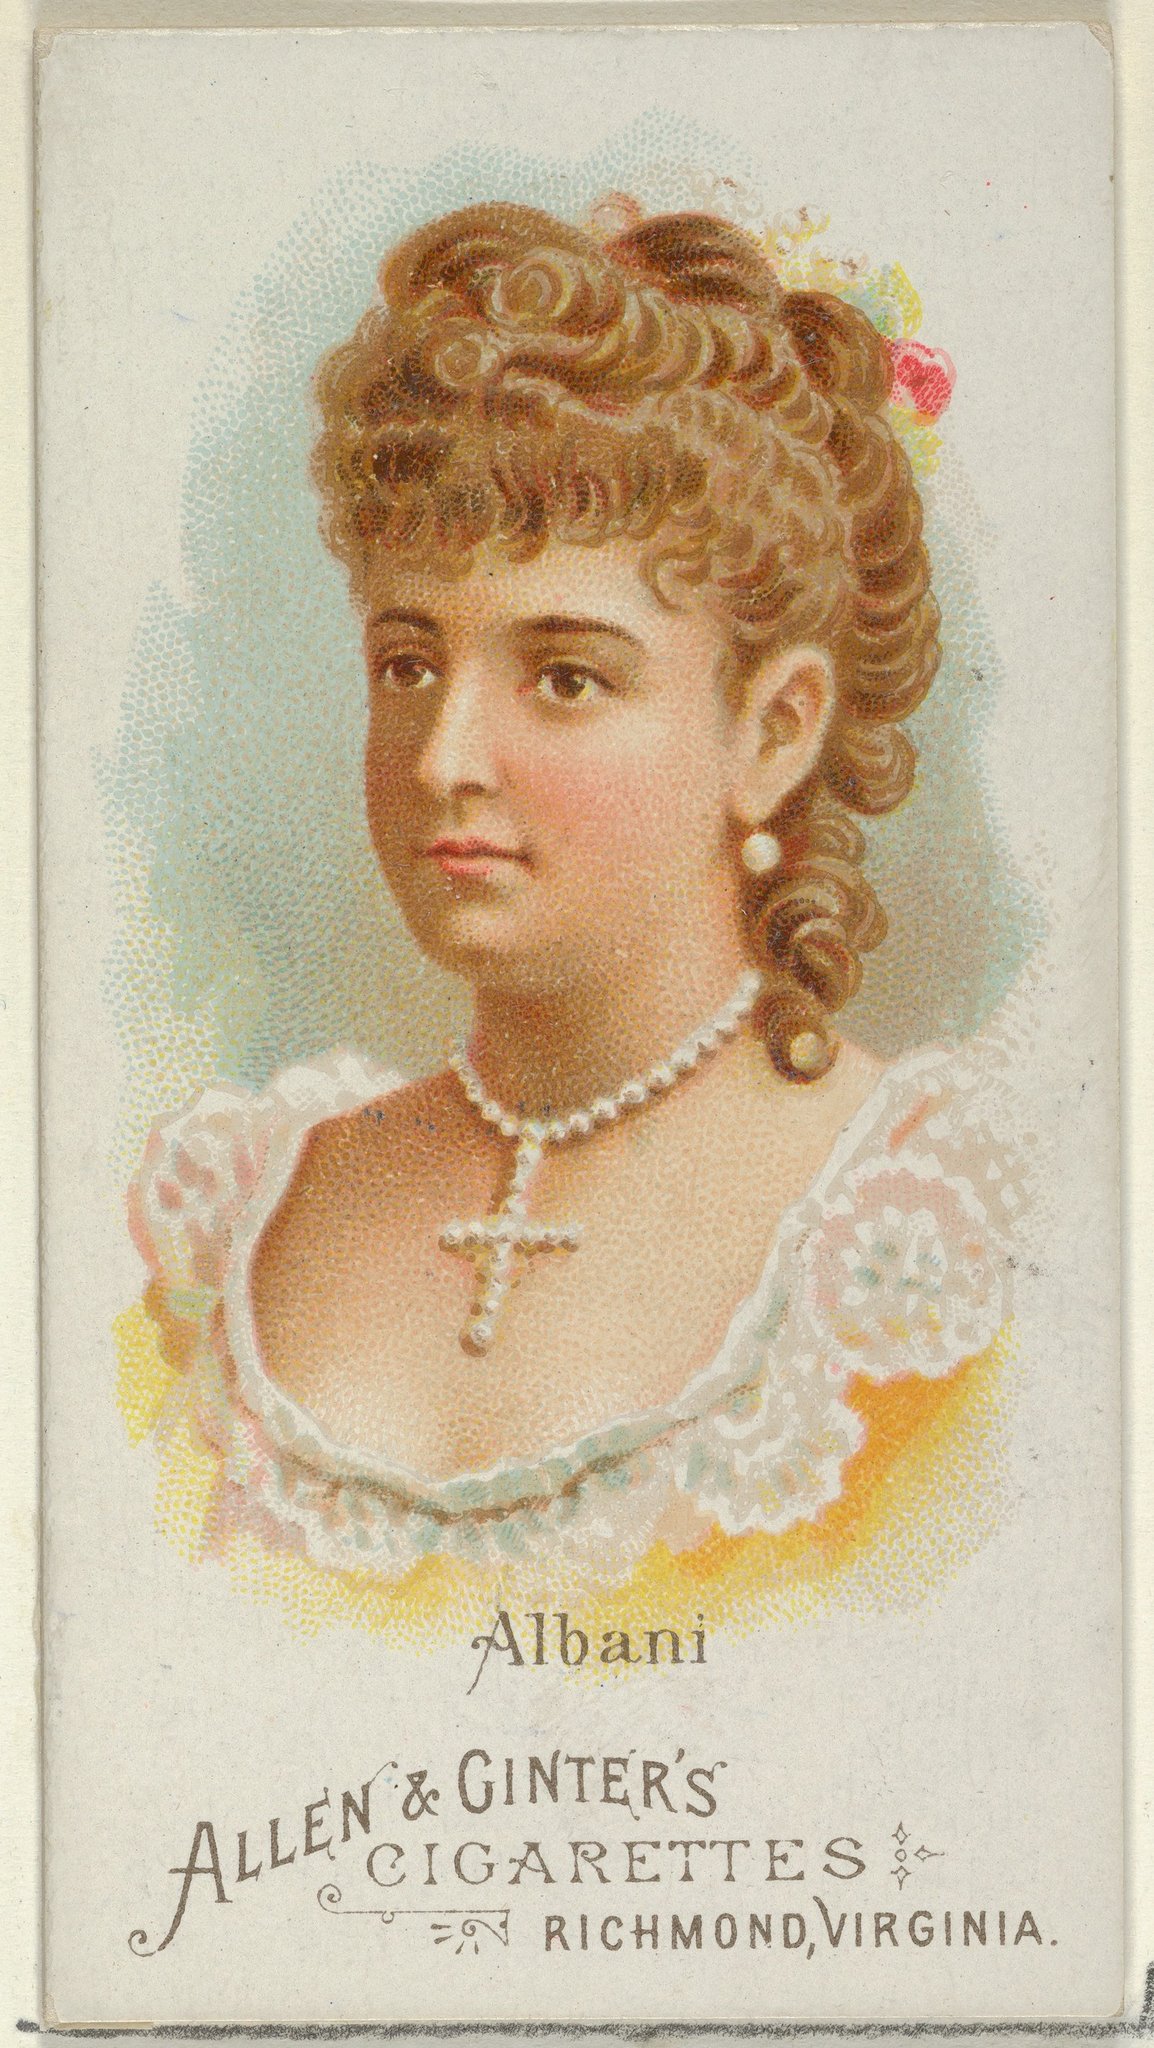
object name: print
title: Albani, from World's Beauties, Series 1 (N26) for Allen & Ginter Cigarettes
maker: allen & ginter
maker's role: publisher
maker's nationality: american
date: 1888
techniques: color lithograph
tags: women